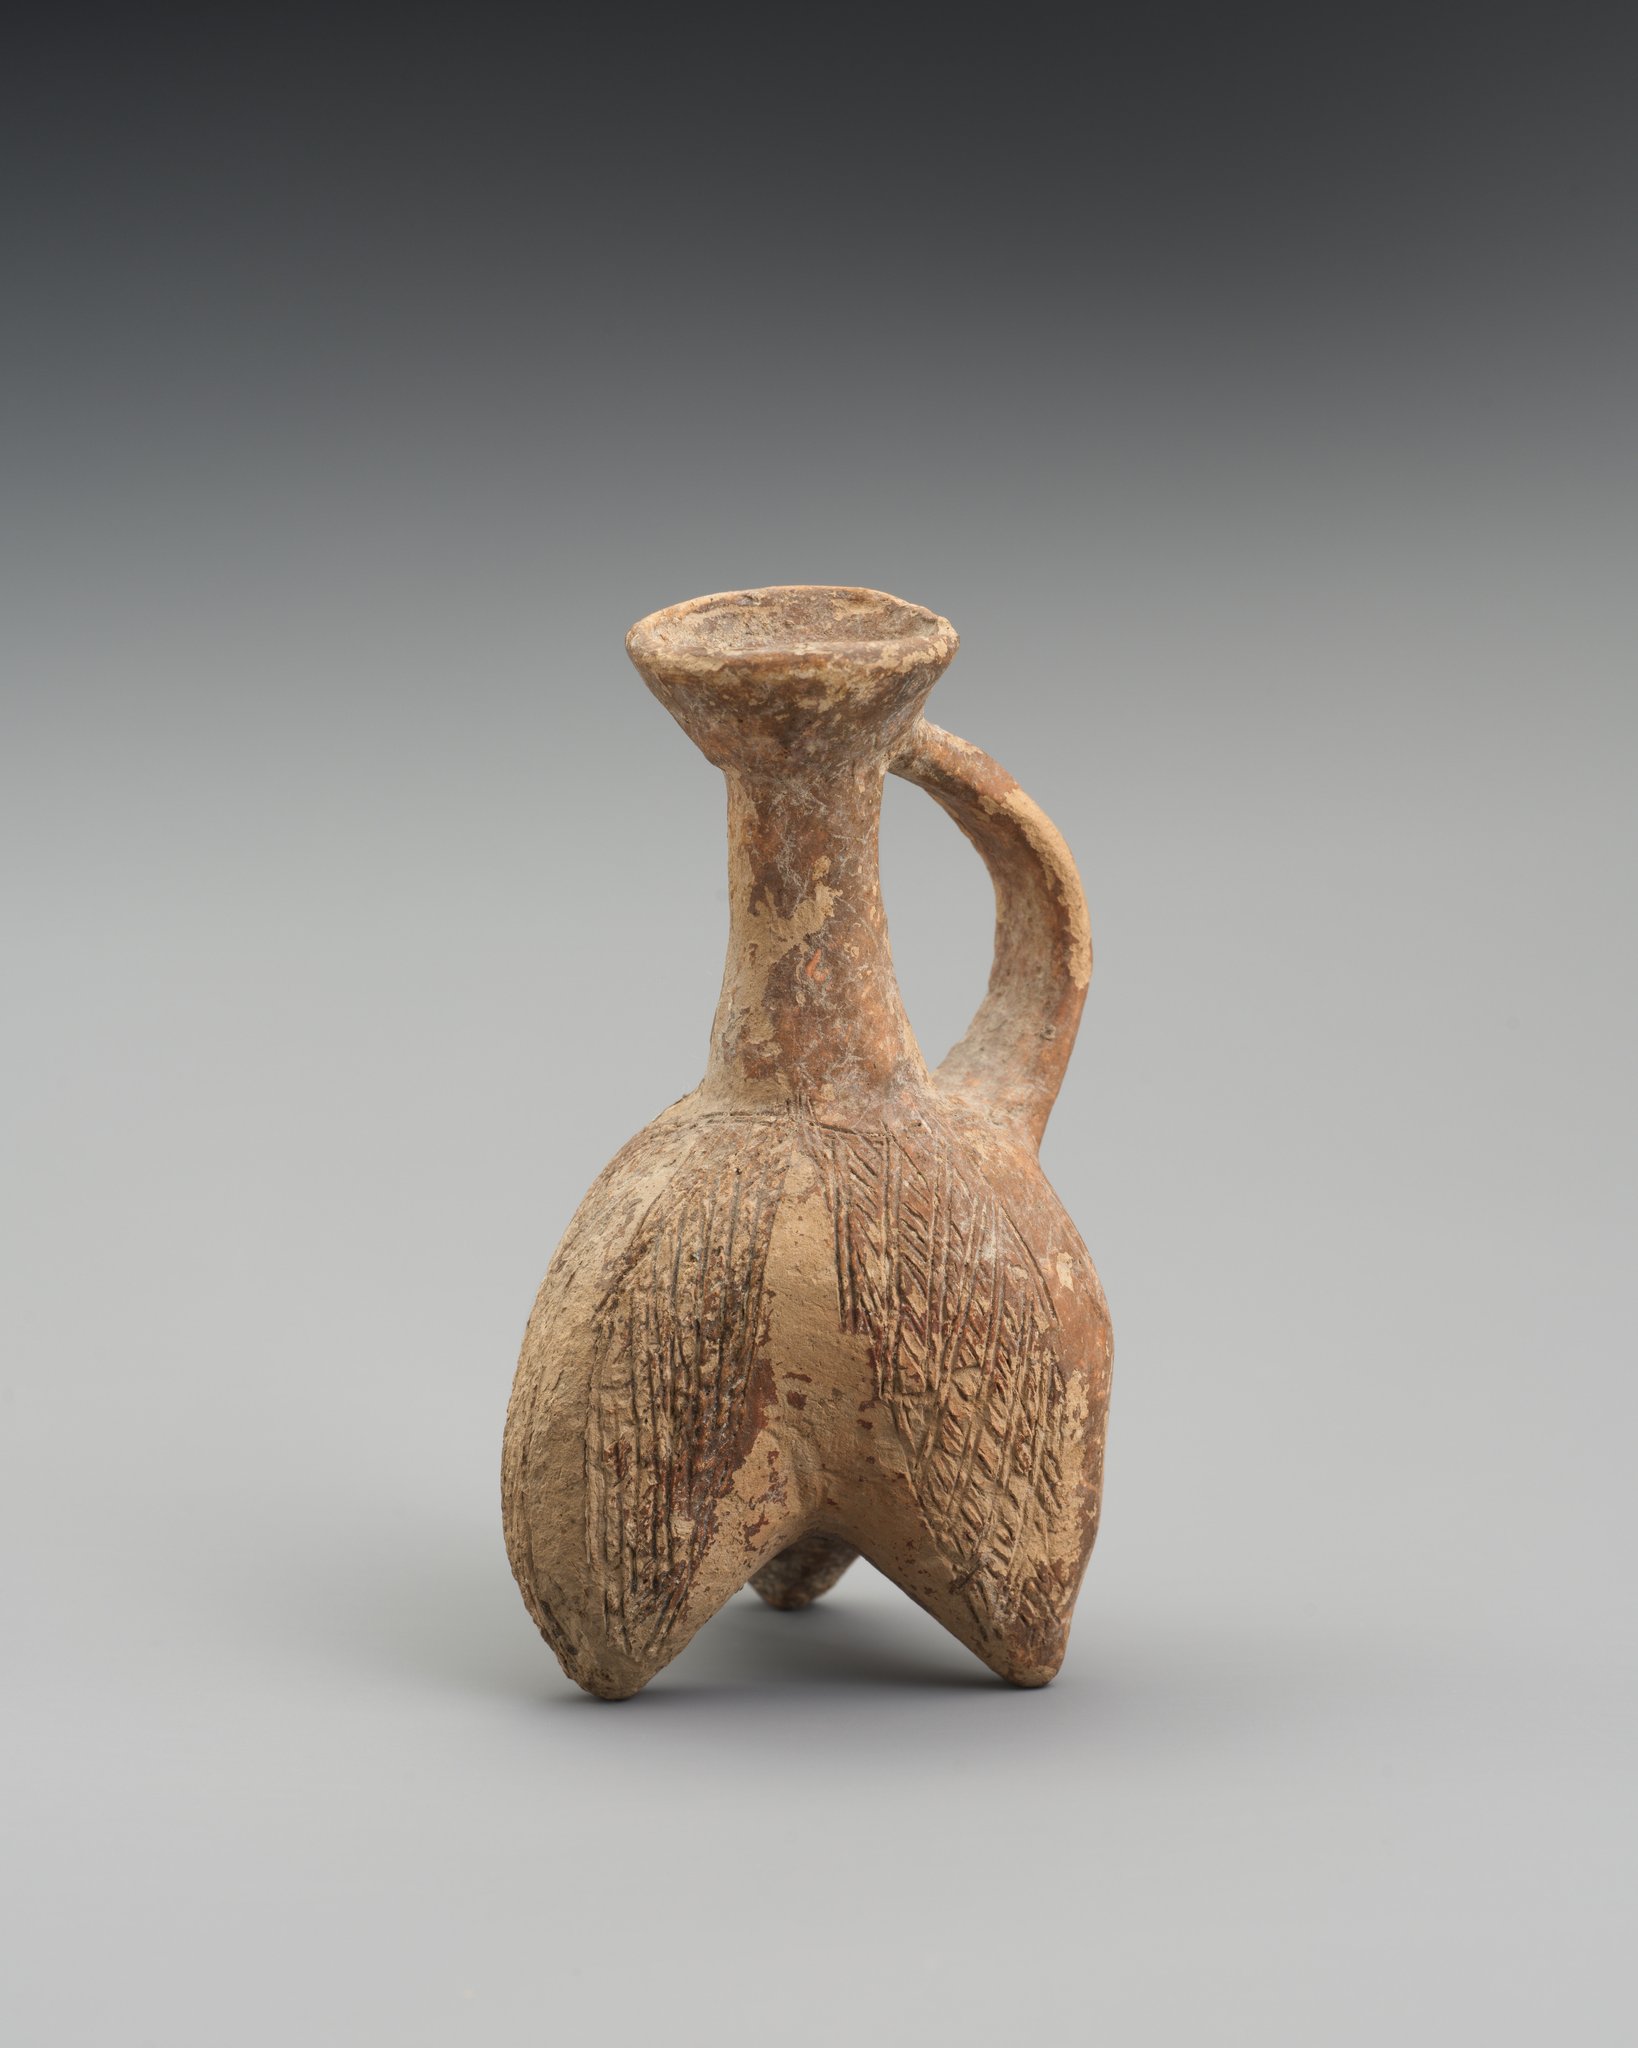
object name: composite jug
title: Terracotta composite jug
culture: cypriot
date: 1725-1600 BCE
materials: terracotta